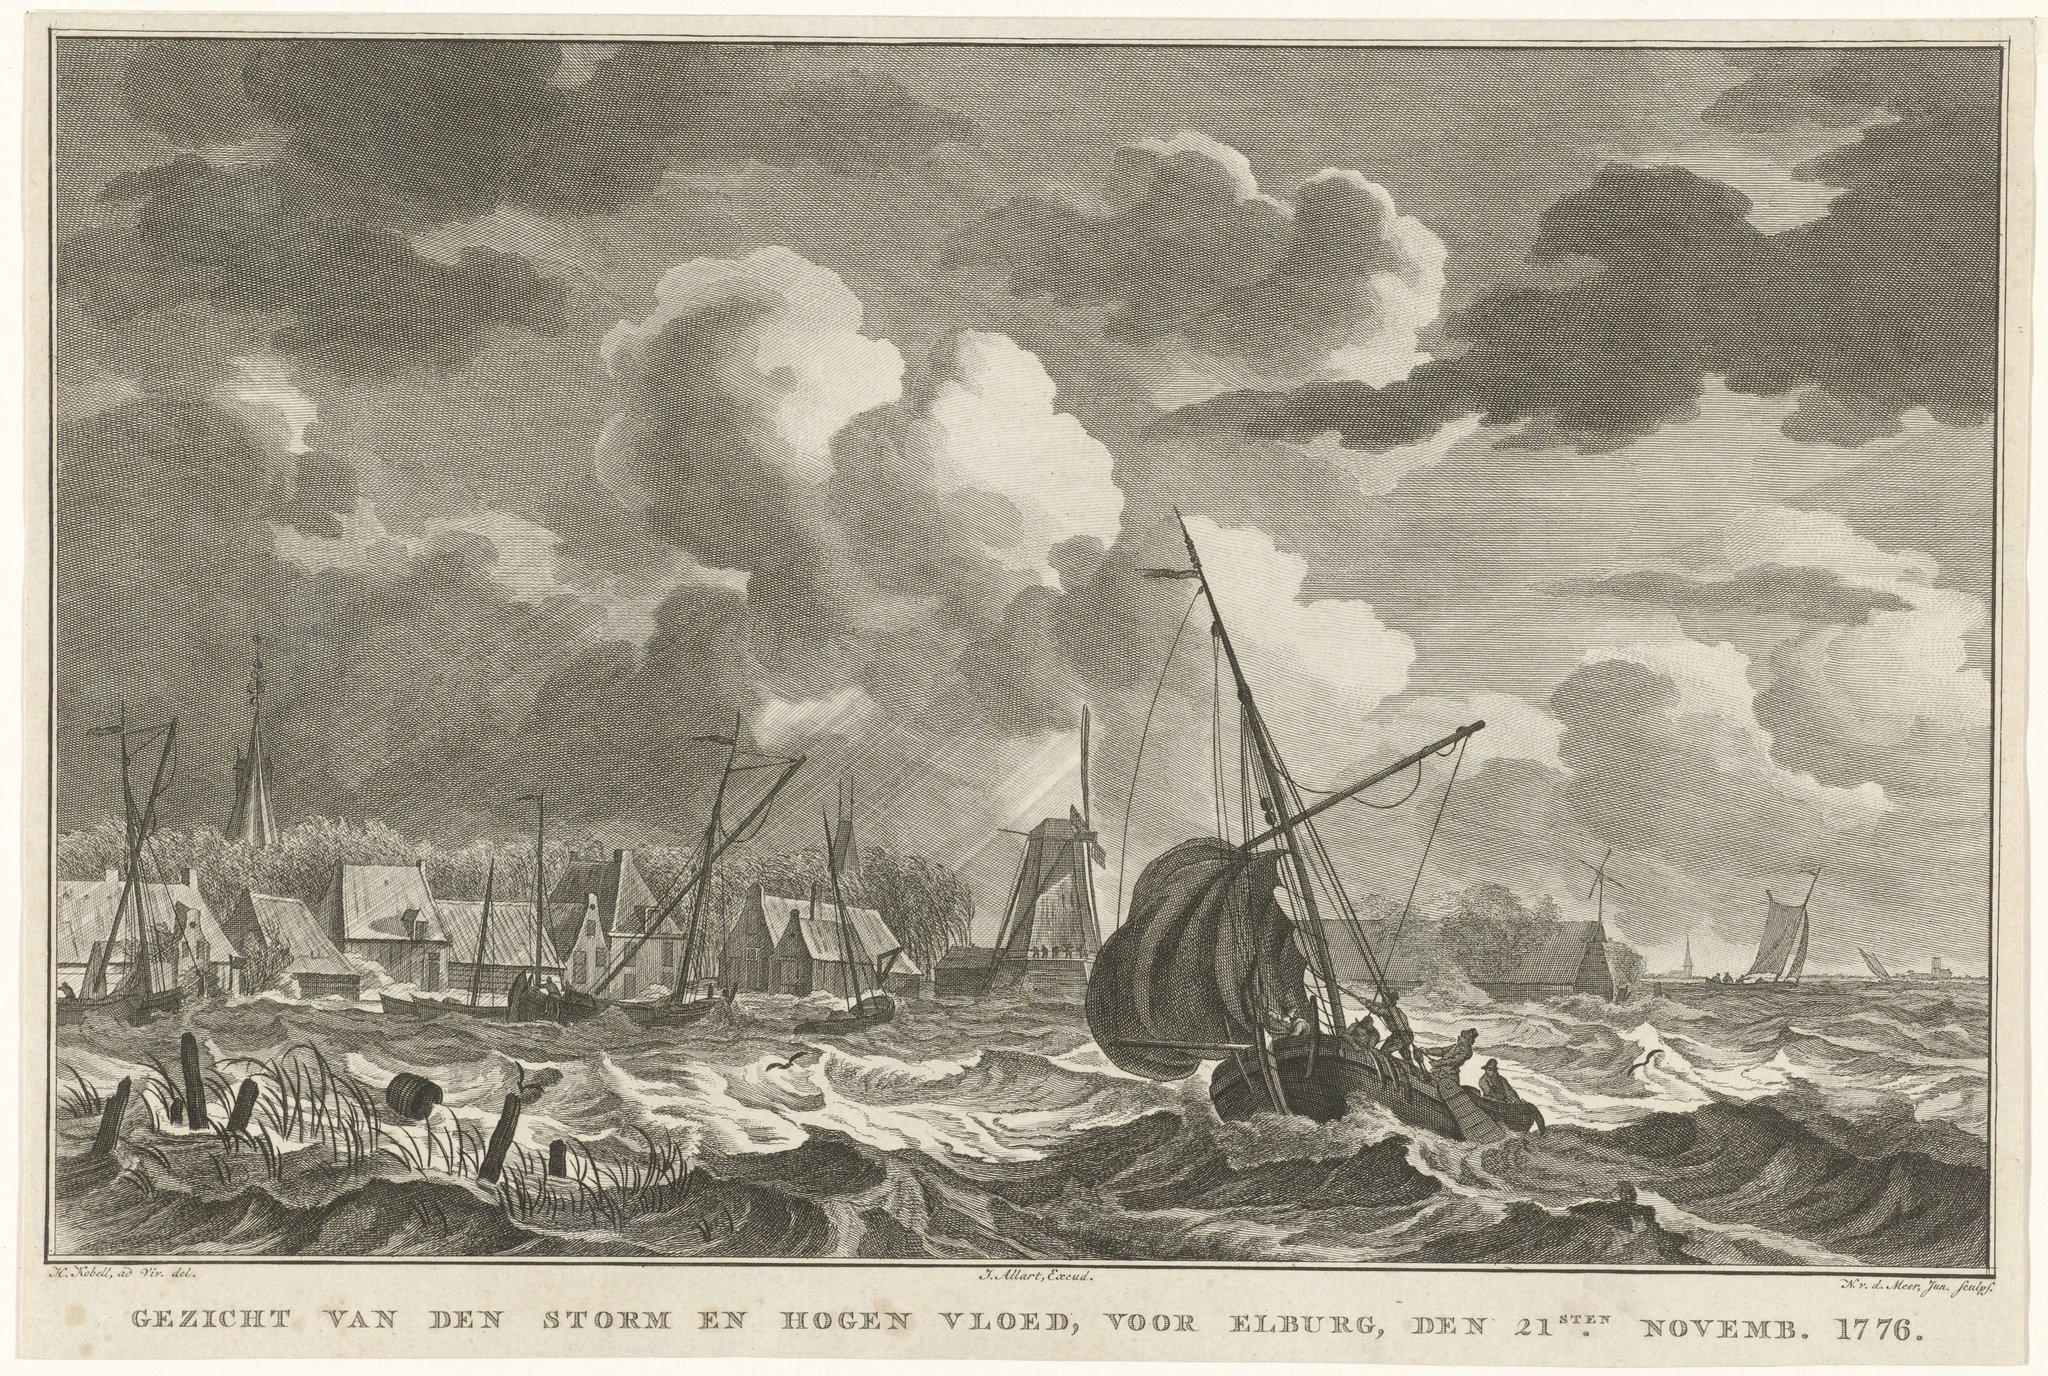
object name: print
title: Storm en hoge vloed bij Elburg, 1776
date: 1778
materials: paper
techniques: engraving, etching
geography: amsterdam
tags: sailing-ship, sailing-boat, flood, storm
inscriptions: collector's mark: Lugt 2228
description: Storm en hoge vloed bij het dorp Elburg op 21 november 1776. Op de voorgrond een schip in nood, waarvan de zeilen worden gehesen. De huizen staan in het water. Onderdeel van een groep illustraties van de watersnood in 1776.